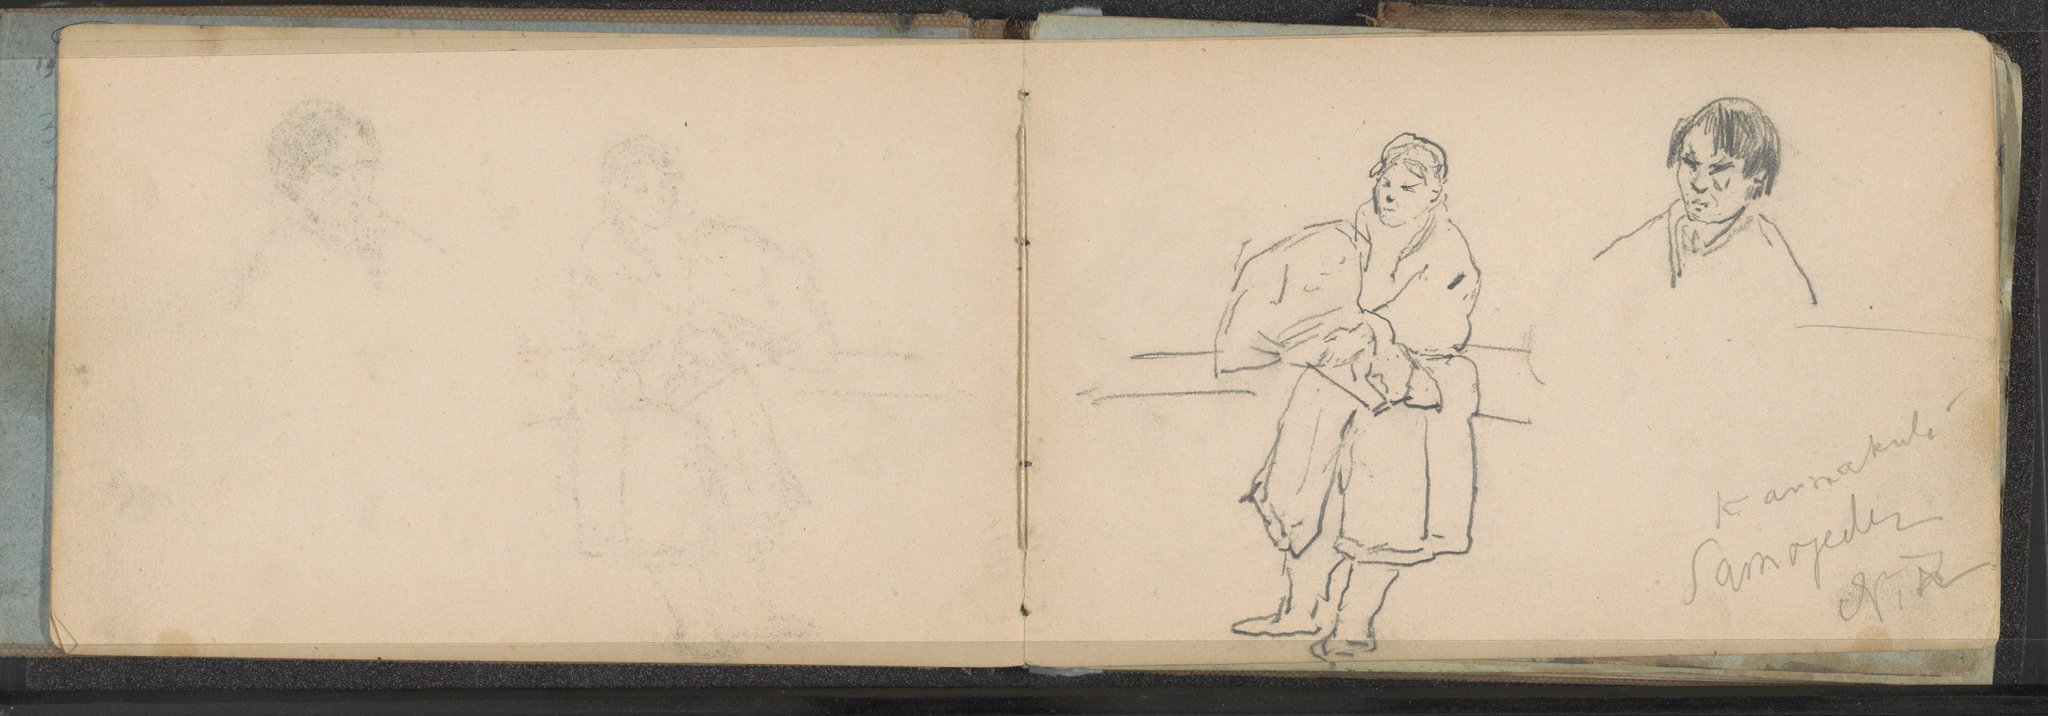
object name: sketchbook leaf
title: Twee Samojeden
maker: louis apol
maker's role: draughtsman, painter, print maker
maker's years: 1850-1936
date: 1880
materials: paper, pencil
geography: malye karmakuly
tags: adult woman, adult man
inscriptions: annotation: ‘Karmakuli/ Samojeden/ N.Z.’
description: Een vrouw en een man. Blad 3 recto uit een schetsboek met 35 bladen betekend tijdens de expeditie naar Nova Zembla in 1880.